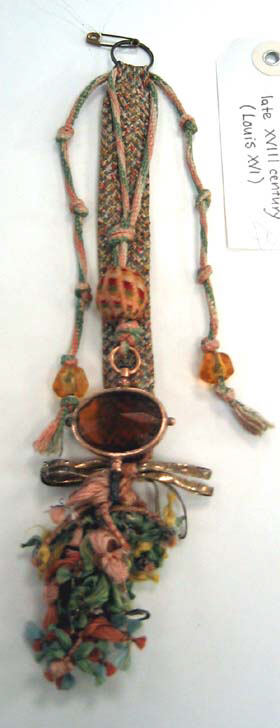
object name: fob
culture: french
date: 1767-1800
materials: glass, metal thread, silk